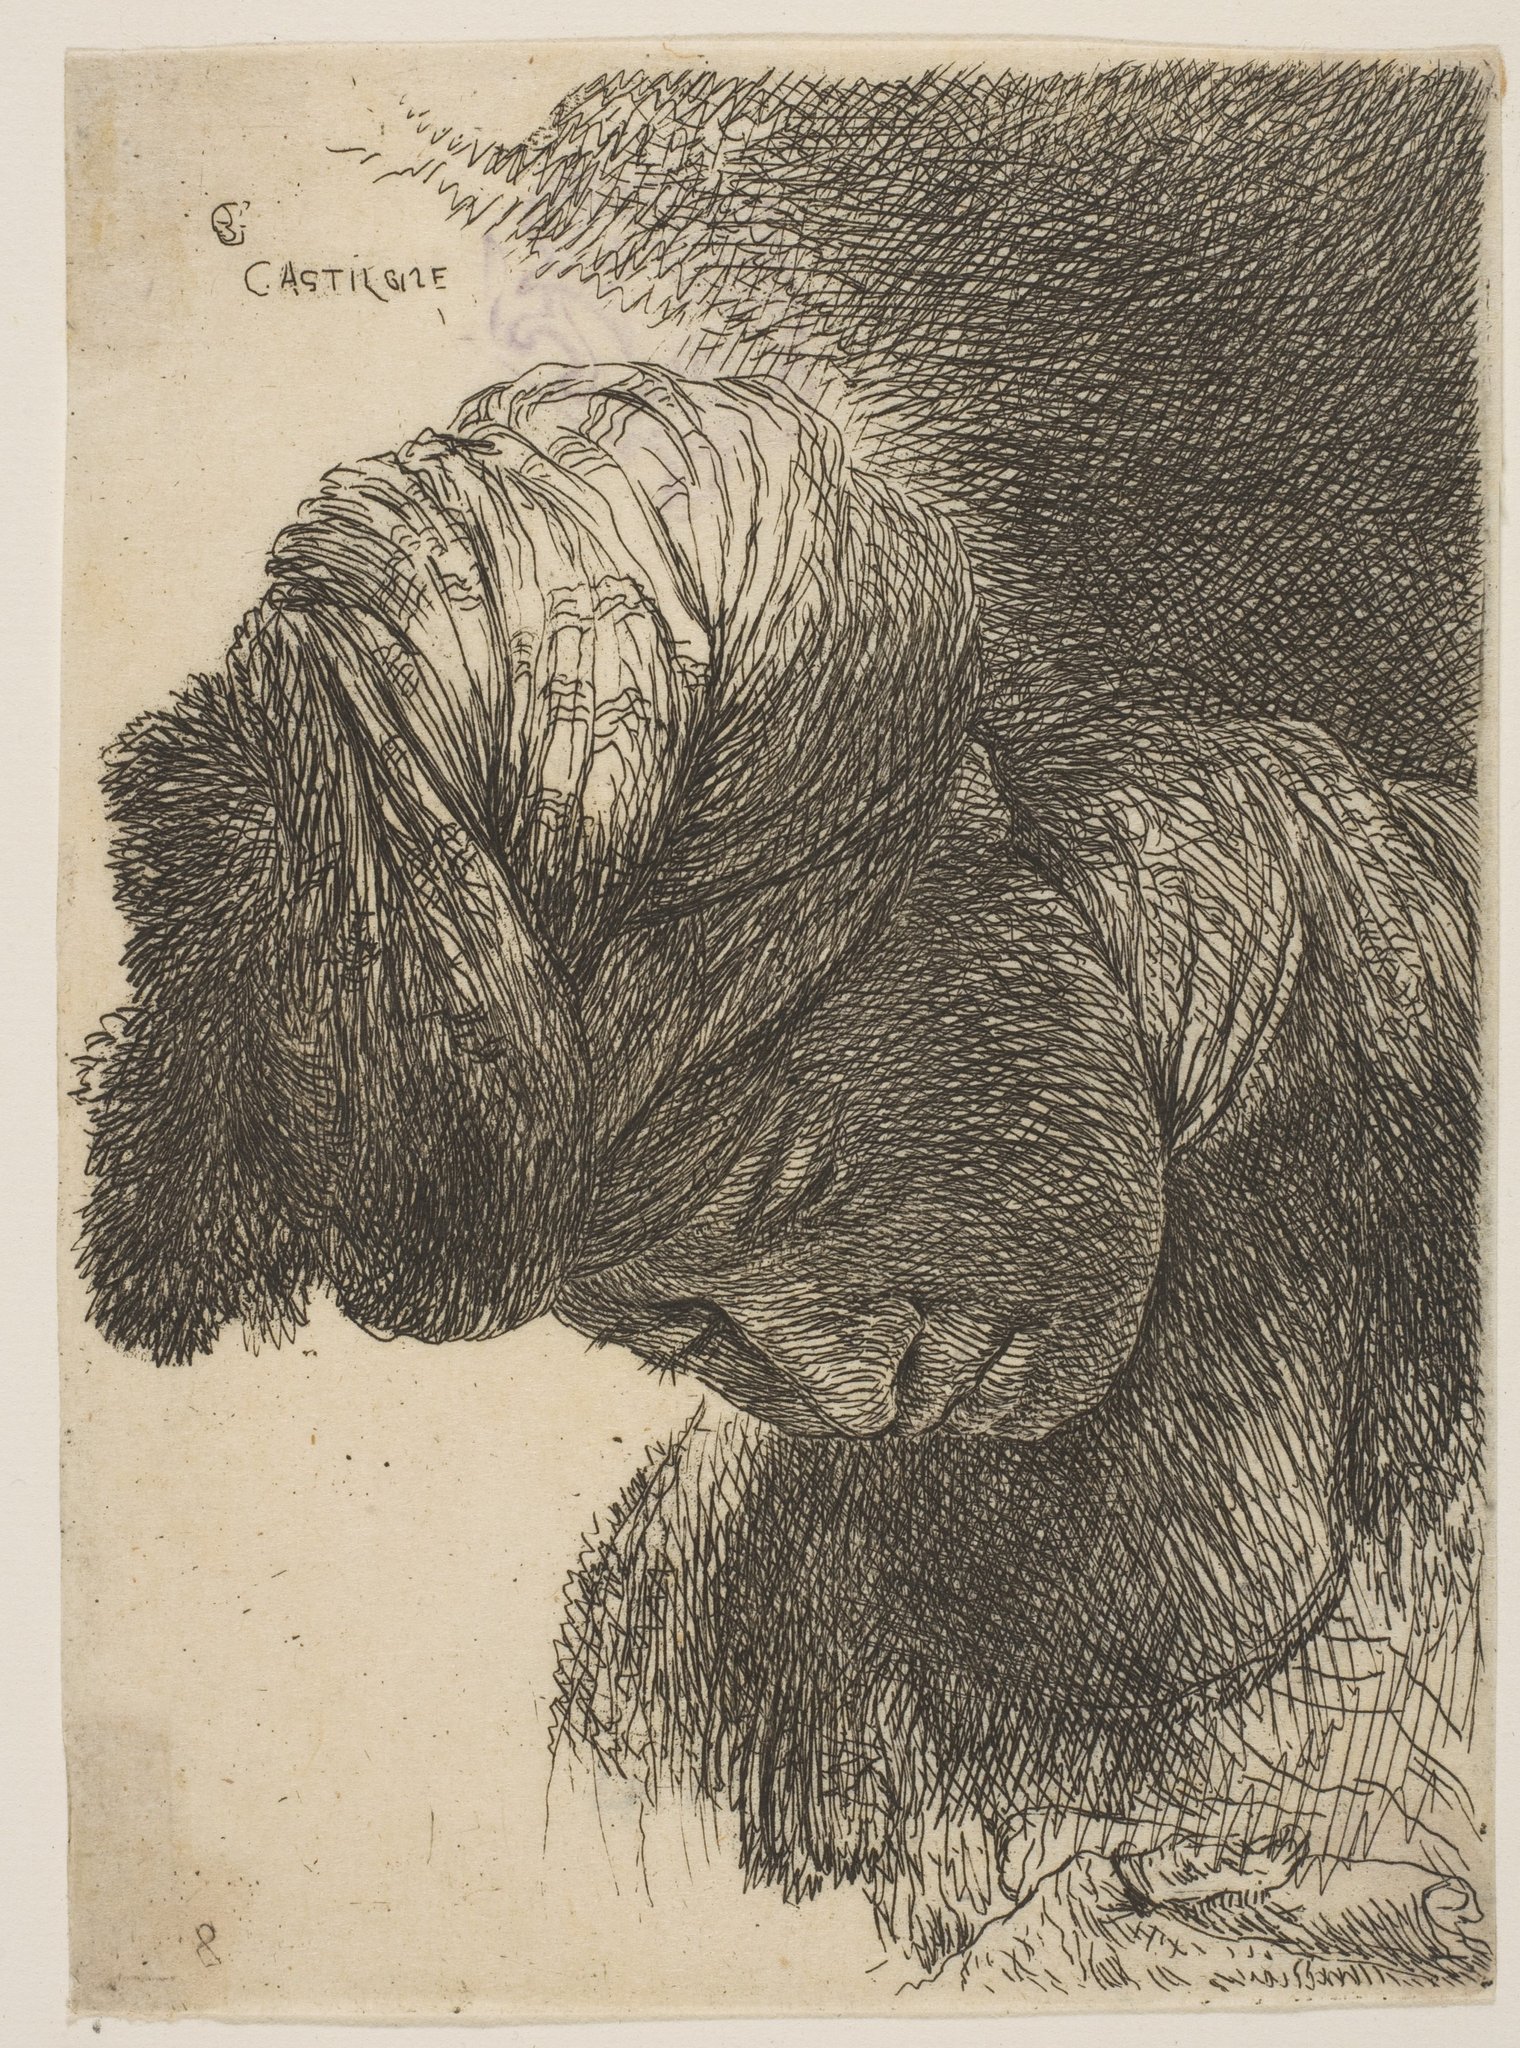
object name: print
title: Young man with his head lowered, wearing a turban, facing left, from the series of 'Small Heads in Oriental Headdress' (19th century impression)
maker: giovanni benedetto castiglione (il grechetto)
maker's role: artist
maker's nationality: italian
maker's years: 1609-1664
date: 1645-1650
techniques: etching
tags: heads,men